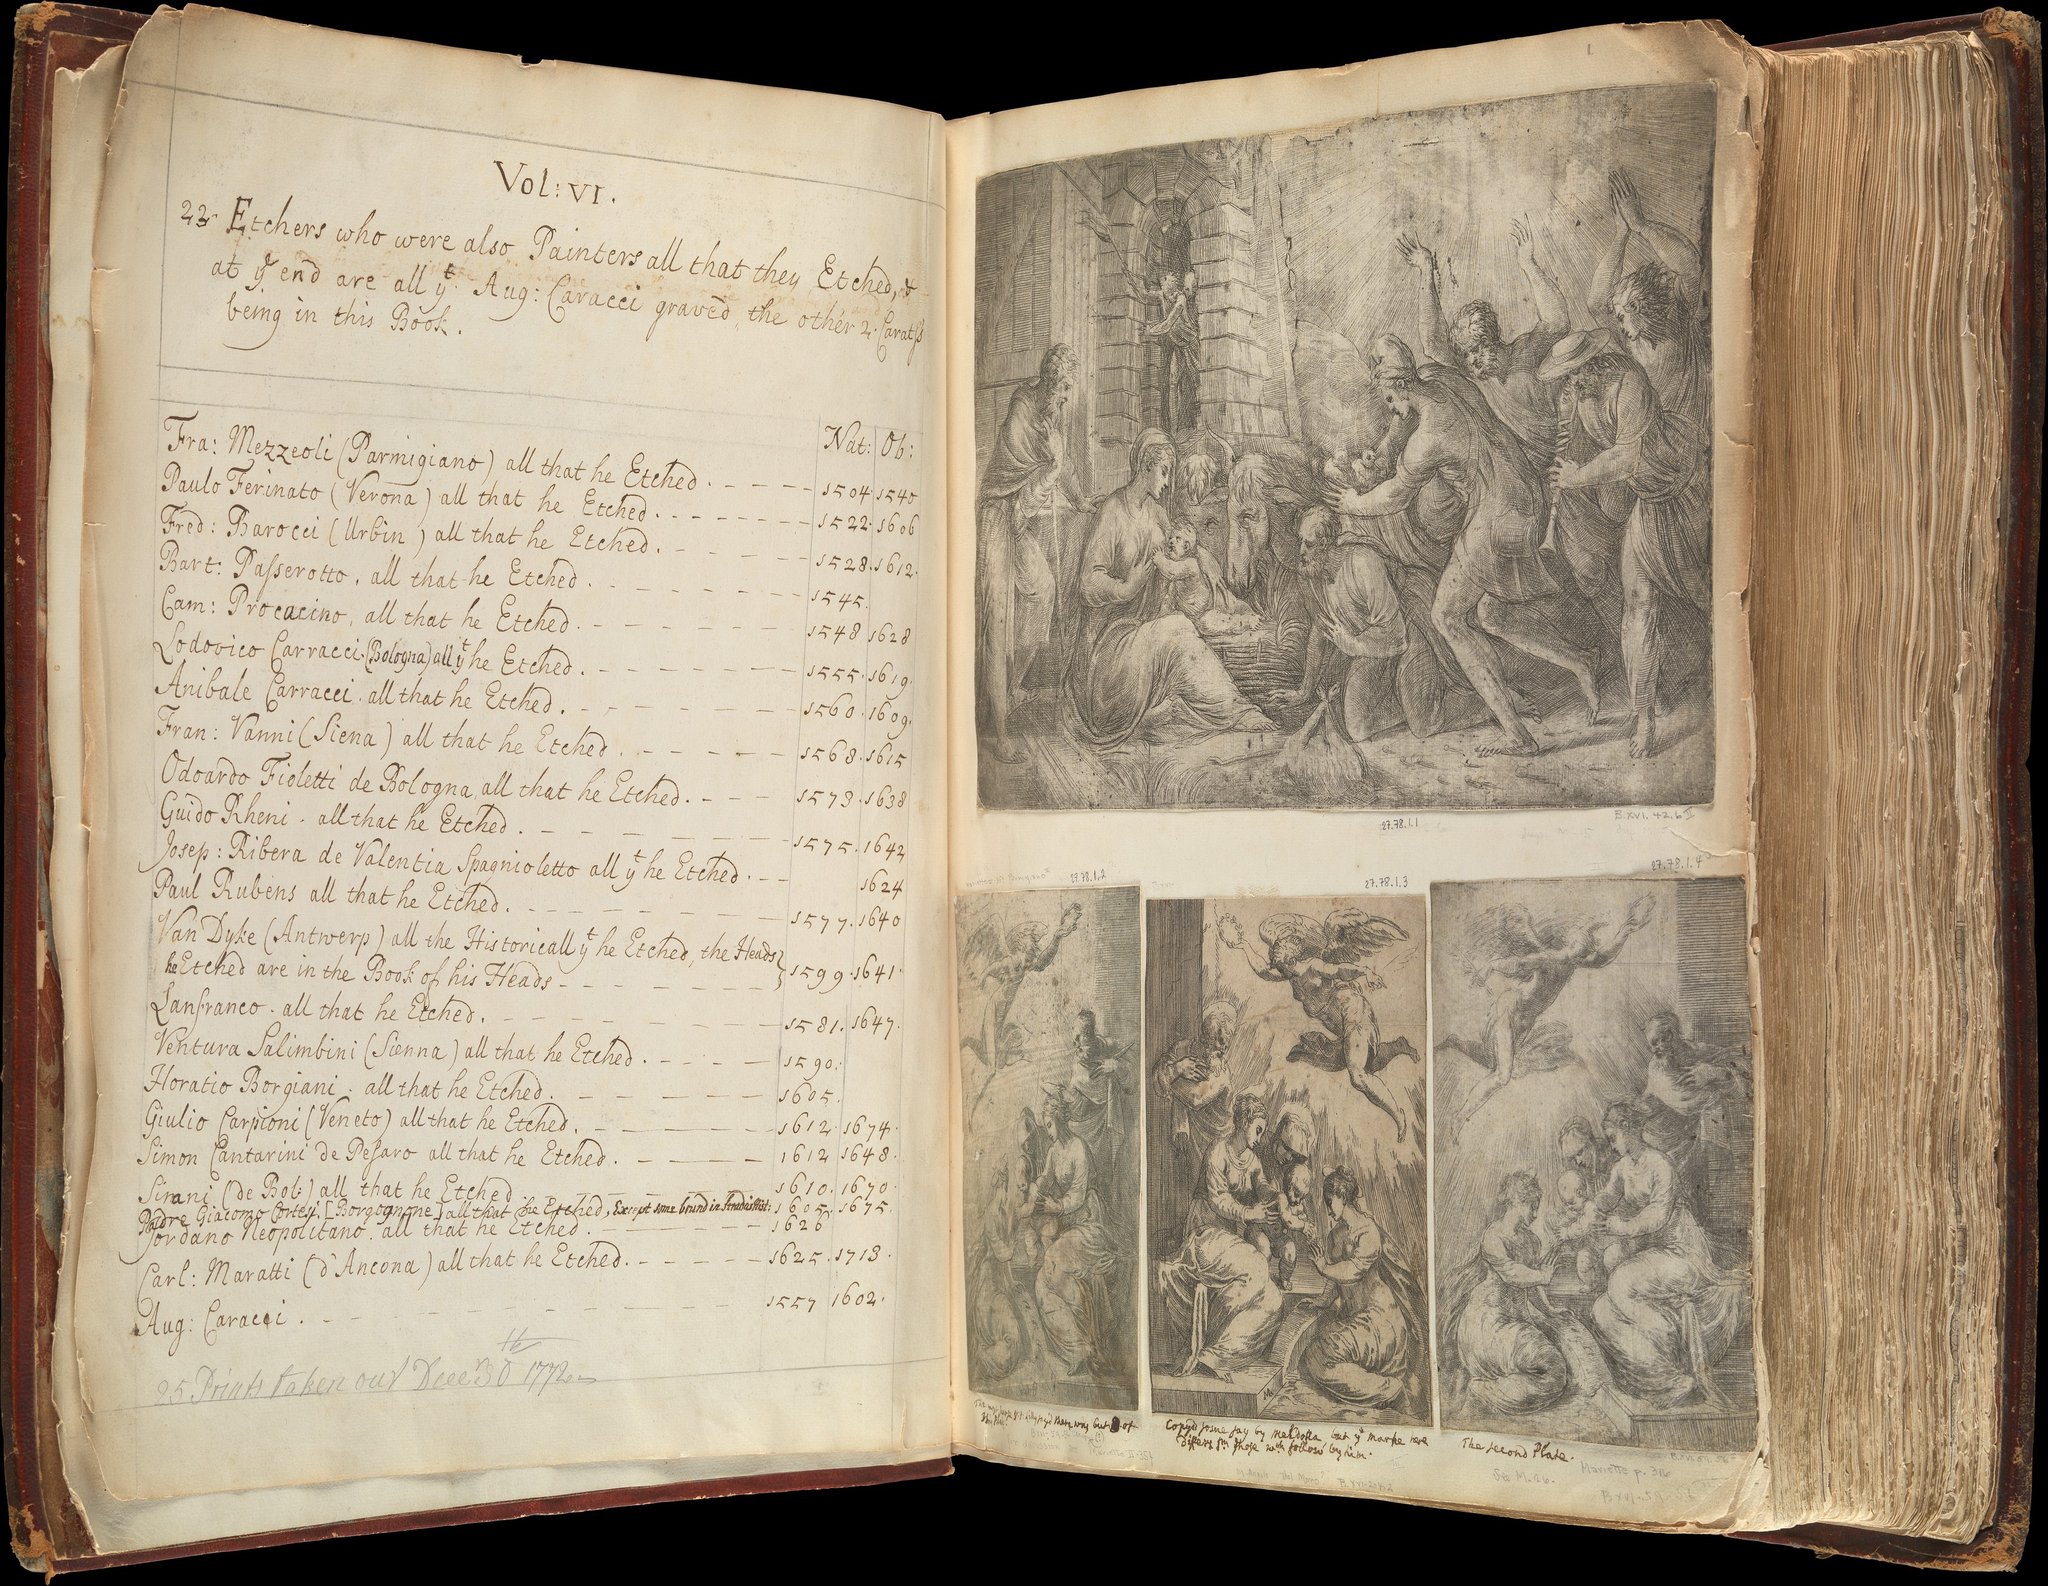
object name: album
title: Chief Etchers and Best Italian (Wilton House Album)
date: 1701-1733